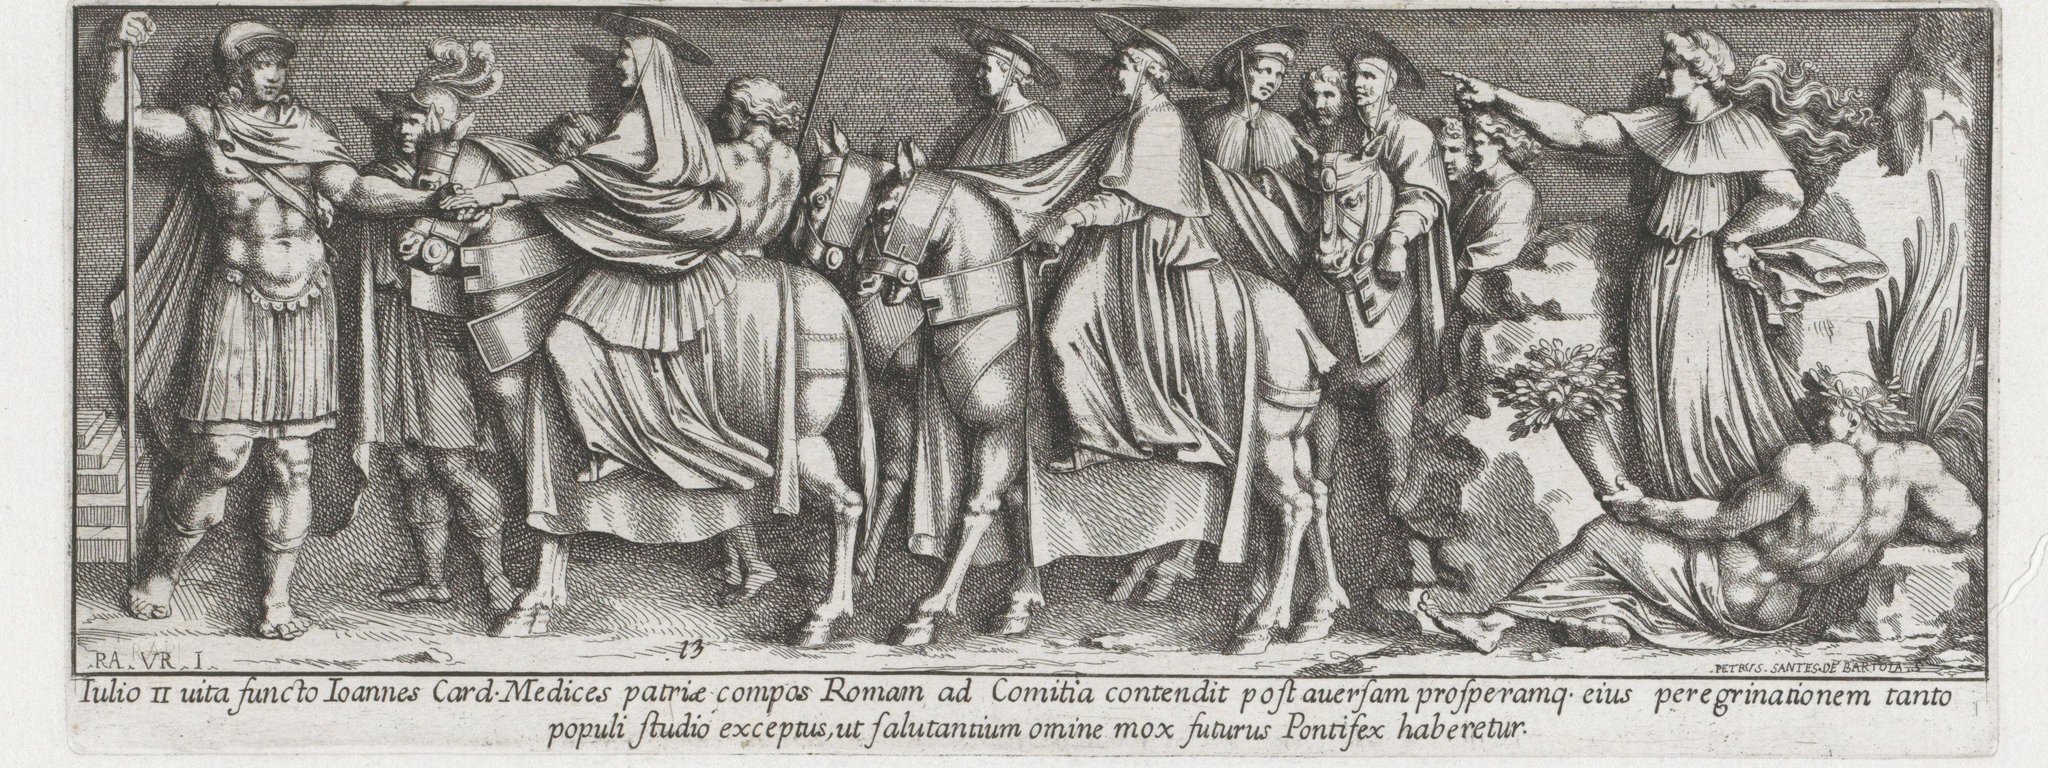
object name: print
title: Iulio II vita functo Ioannes car. Medices patriae compos Romam ad comitia contendit post adversam prosperamque eius peregrinationem tanto / populi studio exceptus, ut salutantium omine mox futurus pontifex haberetur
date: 1645-1700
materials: paper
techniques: engraving, etching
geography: vatican city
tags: rome, leo x, cardinal, arrival and return ~ travelling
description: Giovanni de' Medici en zijn gevolg gaan te paard naar Rome om deel te nemen aan het conclaaf. Links een Romeinse soldaat. Titel in ondermarge. Genummerd midden onder: 13.